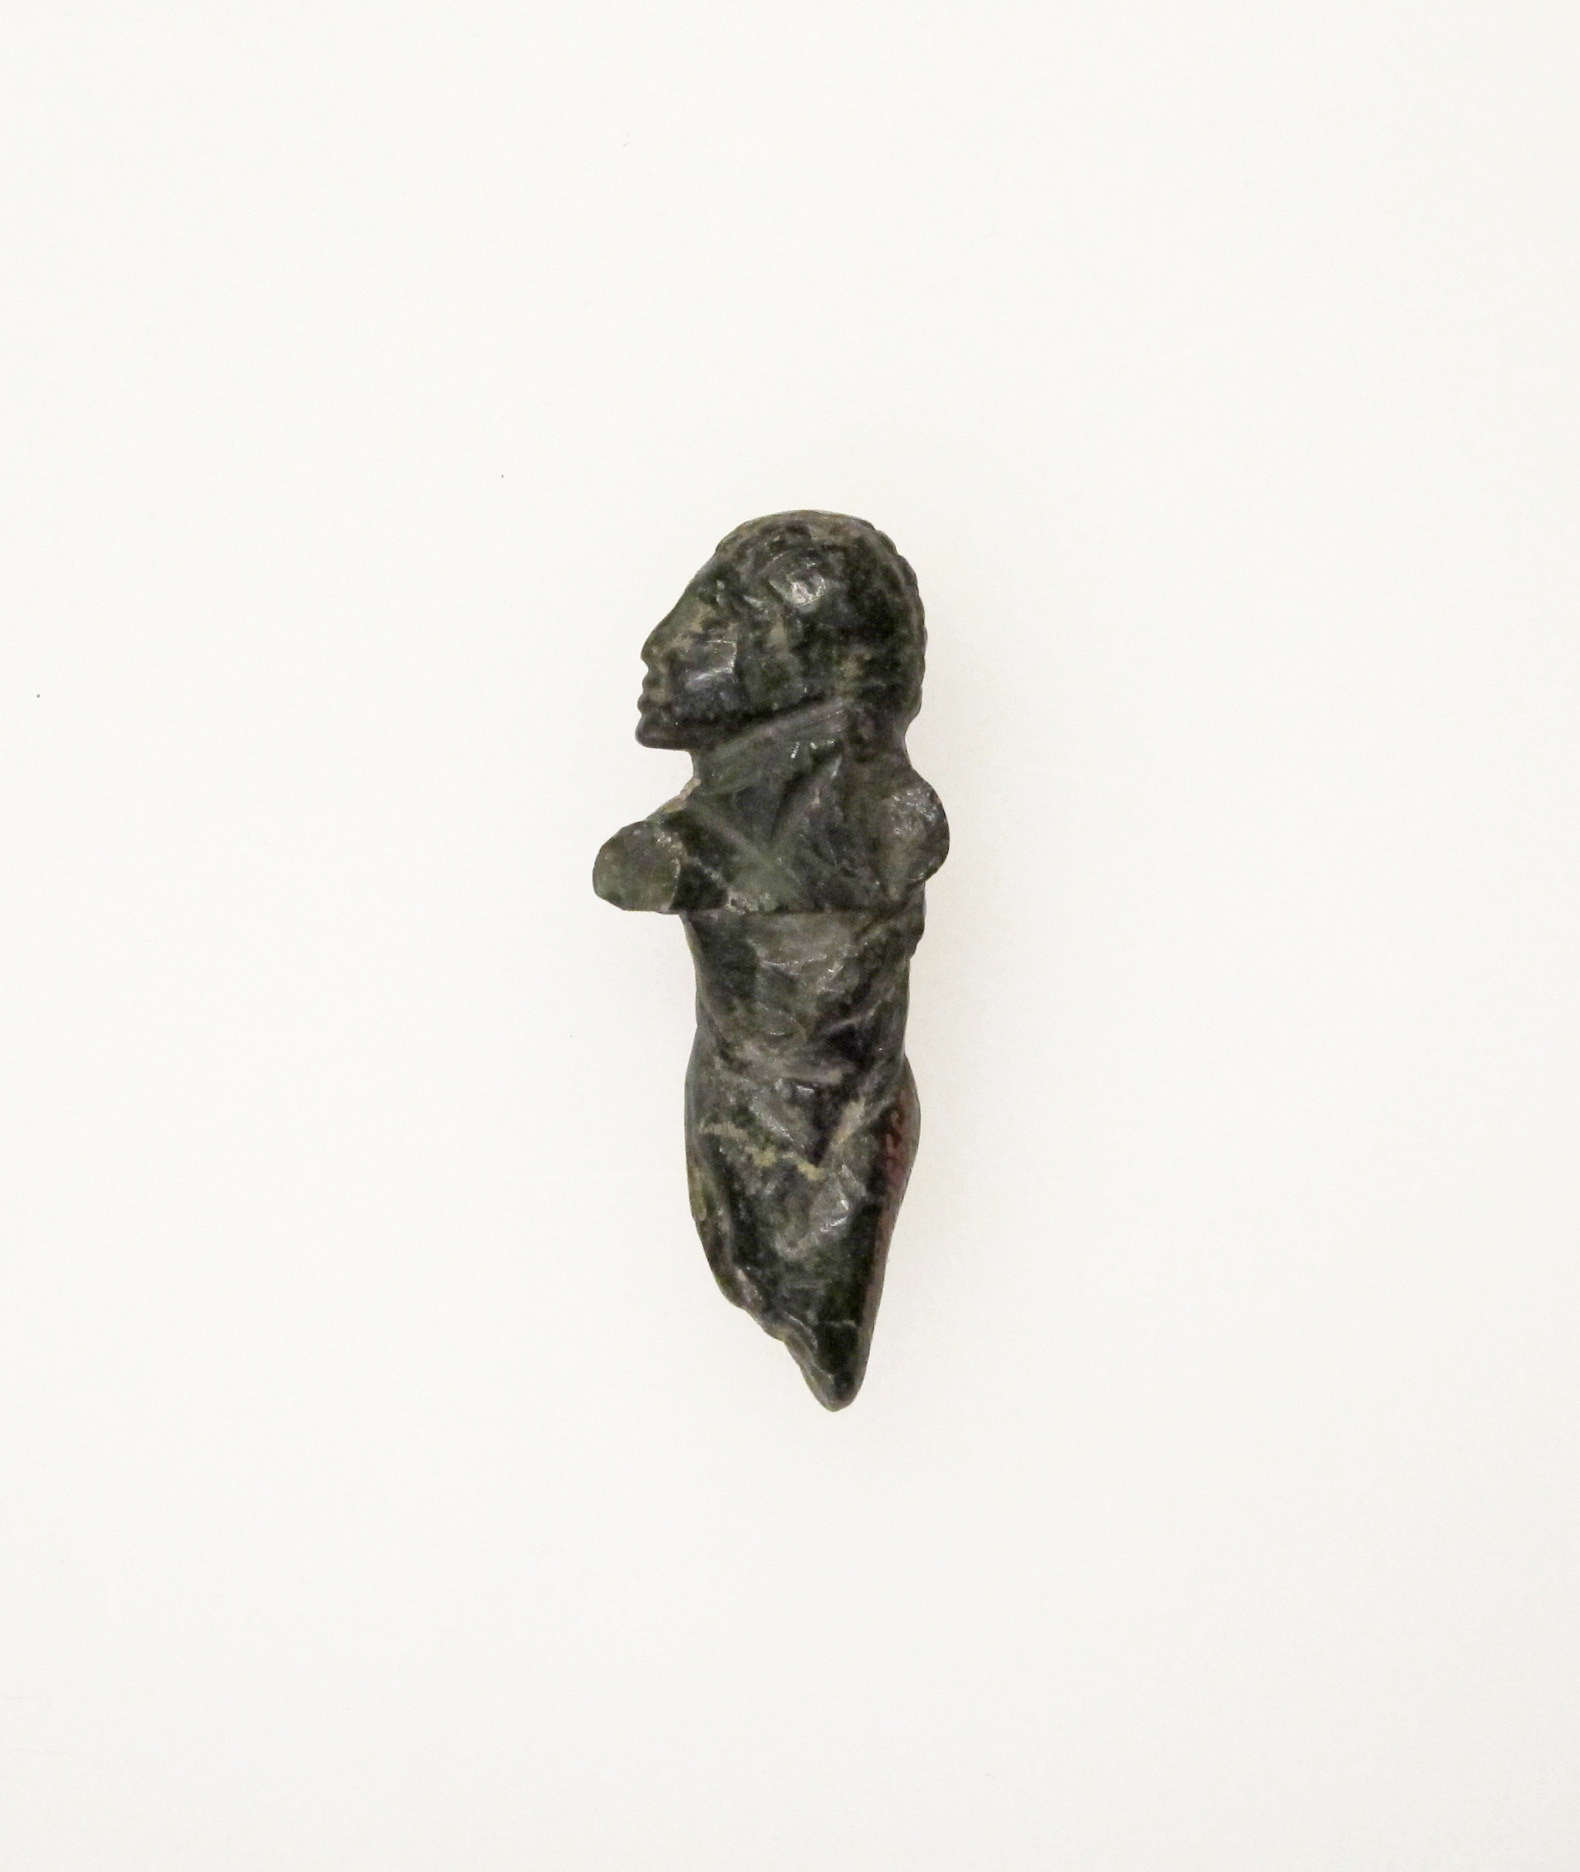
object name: statuette of a figure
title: Glass figurine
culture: roman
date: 301-400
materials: glass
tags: human figures